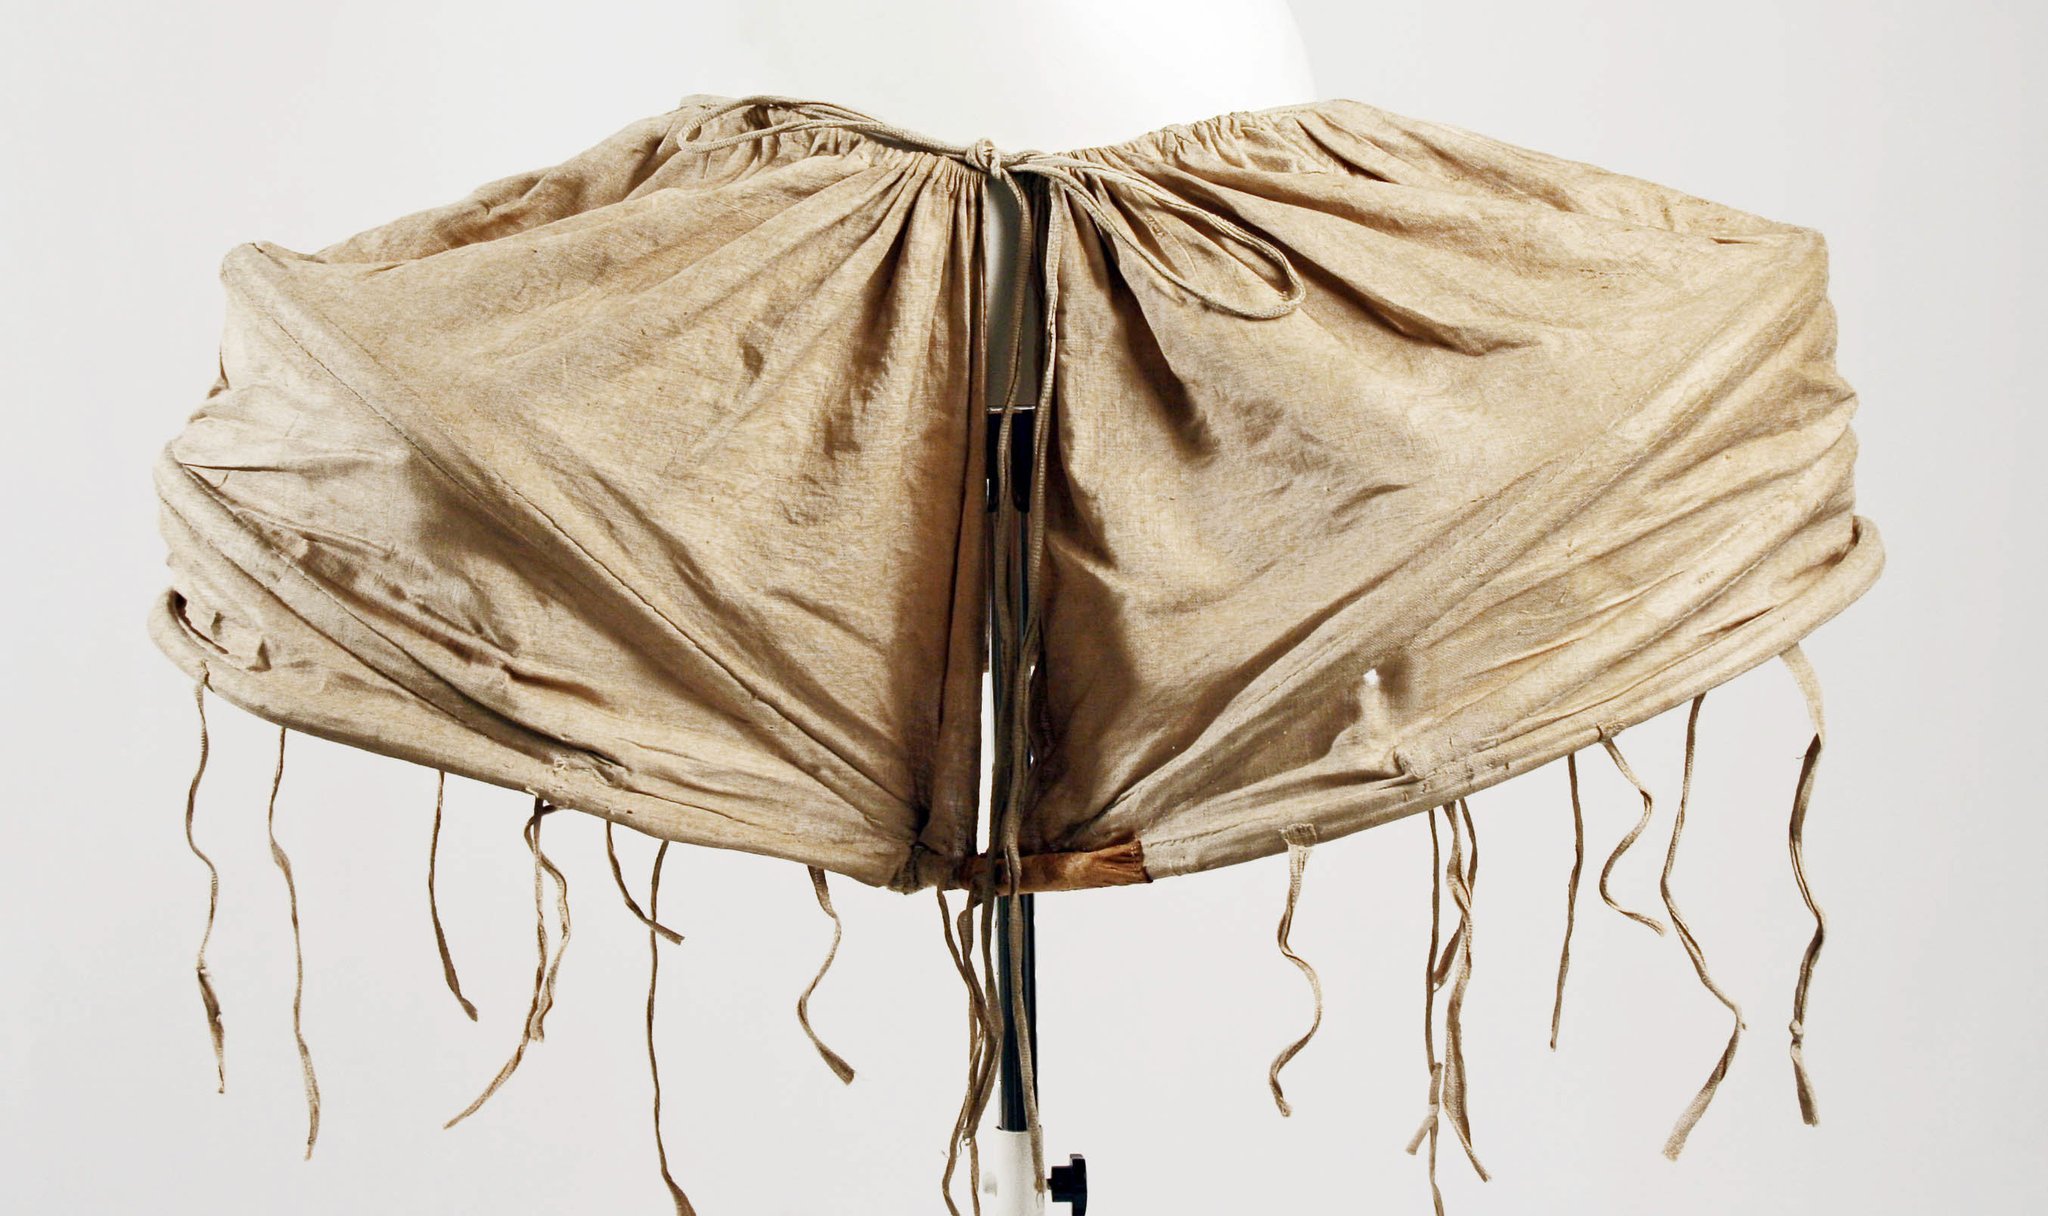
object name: hoop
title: Hoops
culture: italian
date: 1701-1800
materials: linen